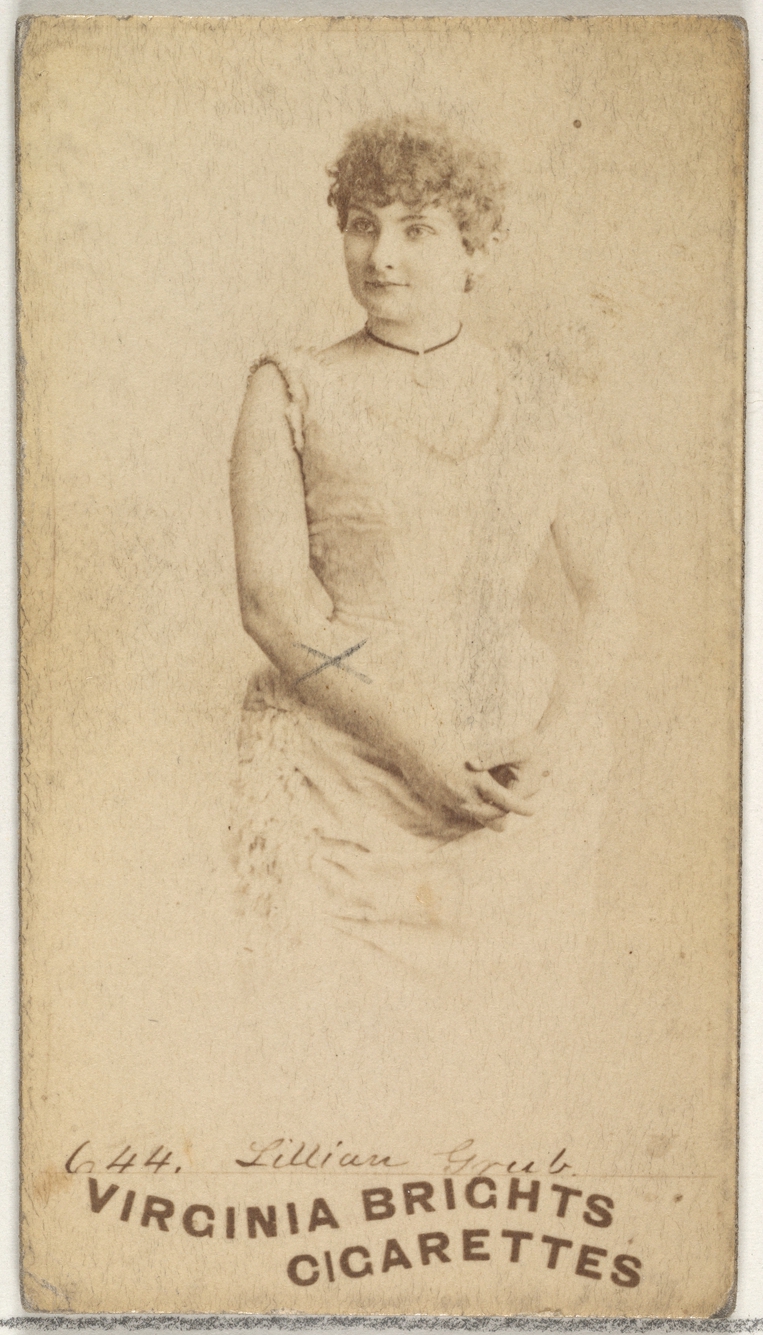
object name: photograph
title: Card 644, Lillian Grub, from the Actors and Actresses series (N45, Type 1) for Virginia Brights Cigarettes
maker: allen & ginter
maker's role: publisher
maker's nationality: american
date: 1888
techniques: albumen silver print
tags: portraits,women,actresses